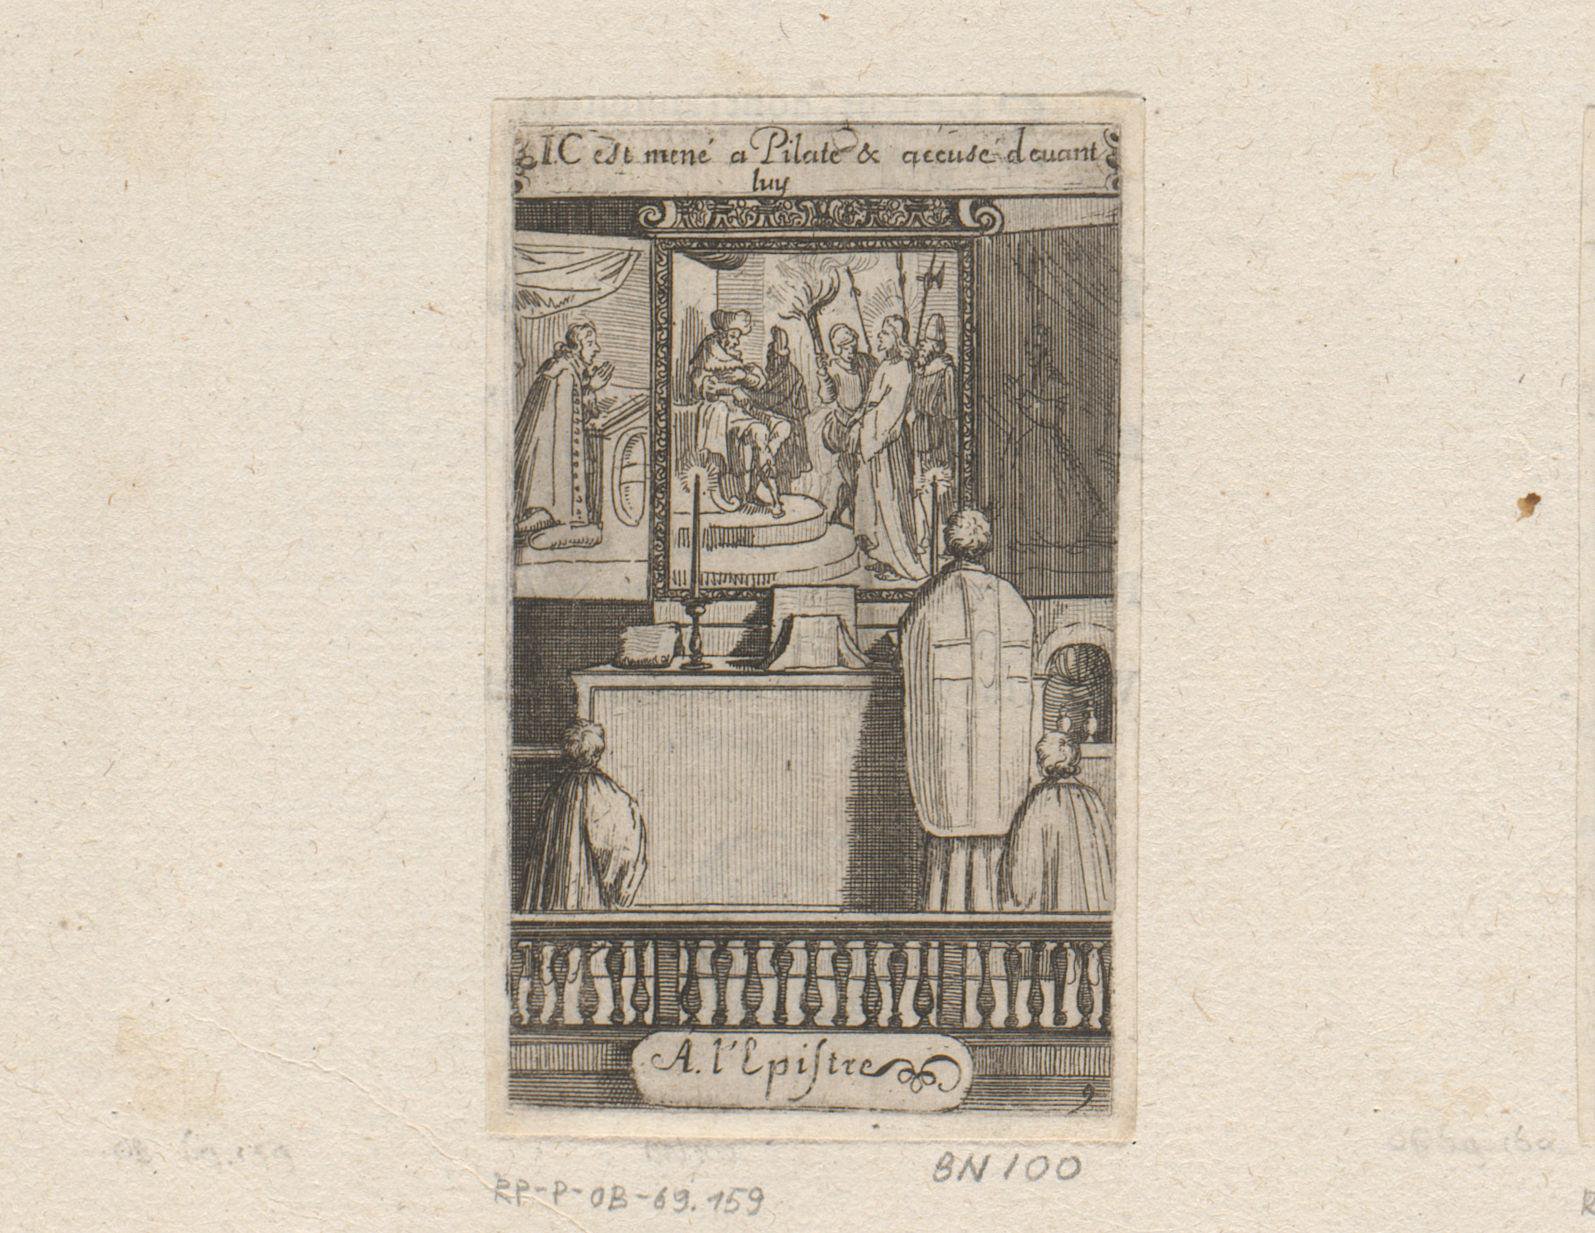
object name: print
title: Priester met twee misdienaars voor een altaar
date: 1661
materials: paper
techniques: etching, letterpress printing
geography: france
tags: priest (roman catholic), altar with altar-piece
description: Prent uit: Mengin, L. Tableaux ou sont representees la passion de N.S. Christ et les actions du prestre a la S. Messe (...). Metz: Claude Bouchard, 1661.